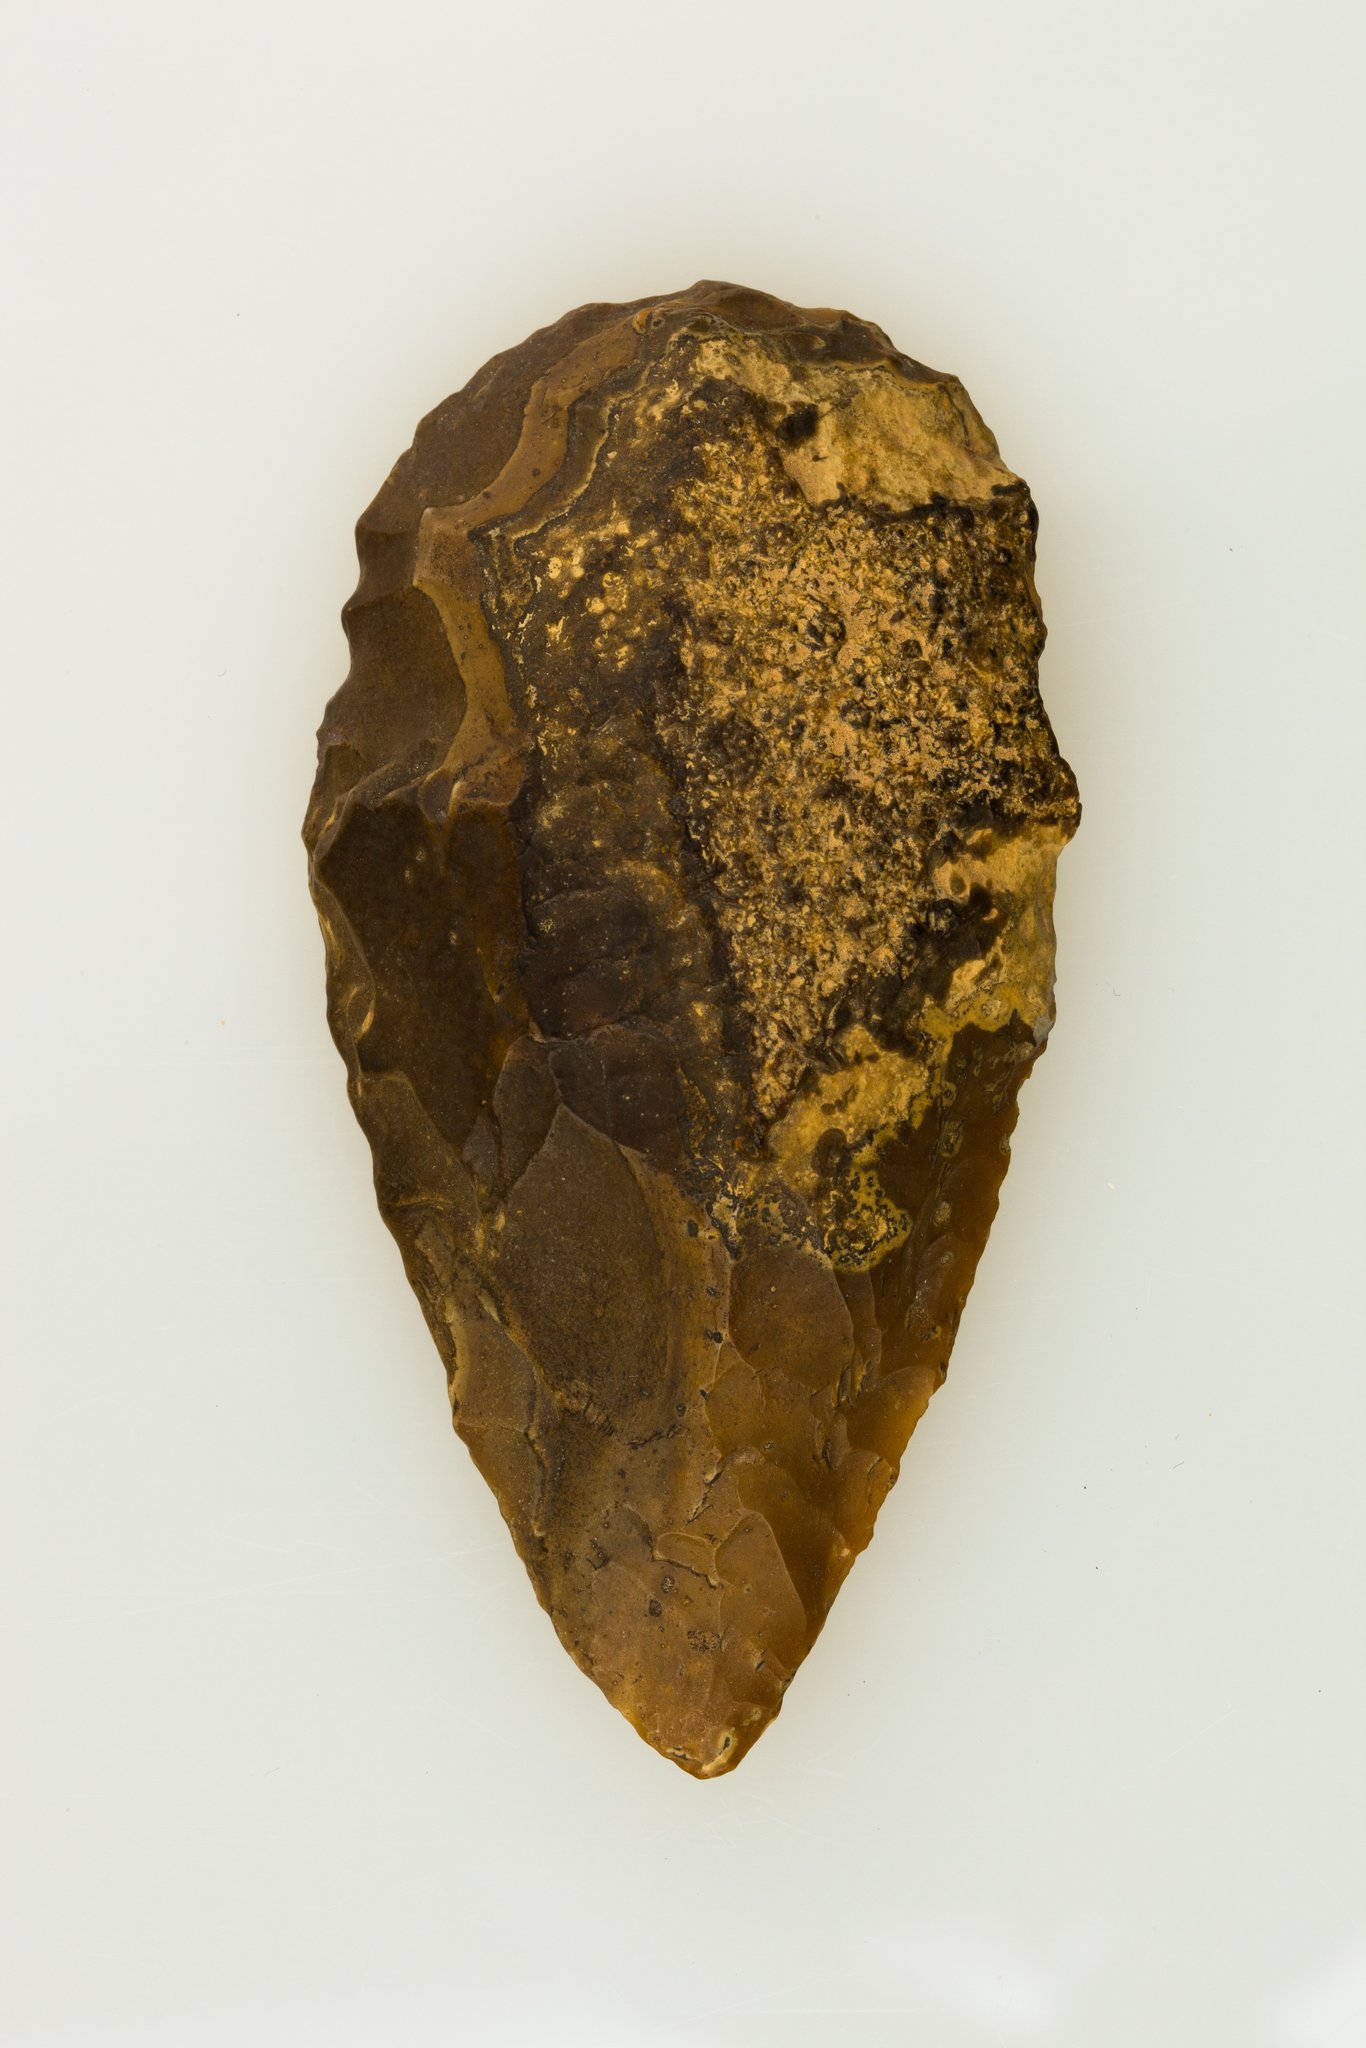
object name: scraper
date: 3850-2960 BCE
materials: stone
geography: egypt